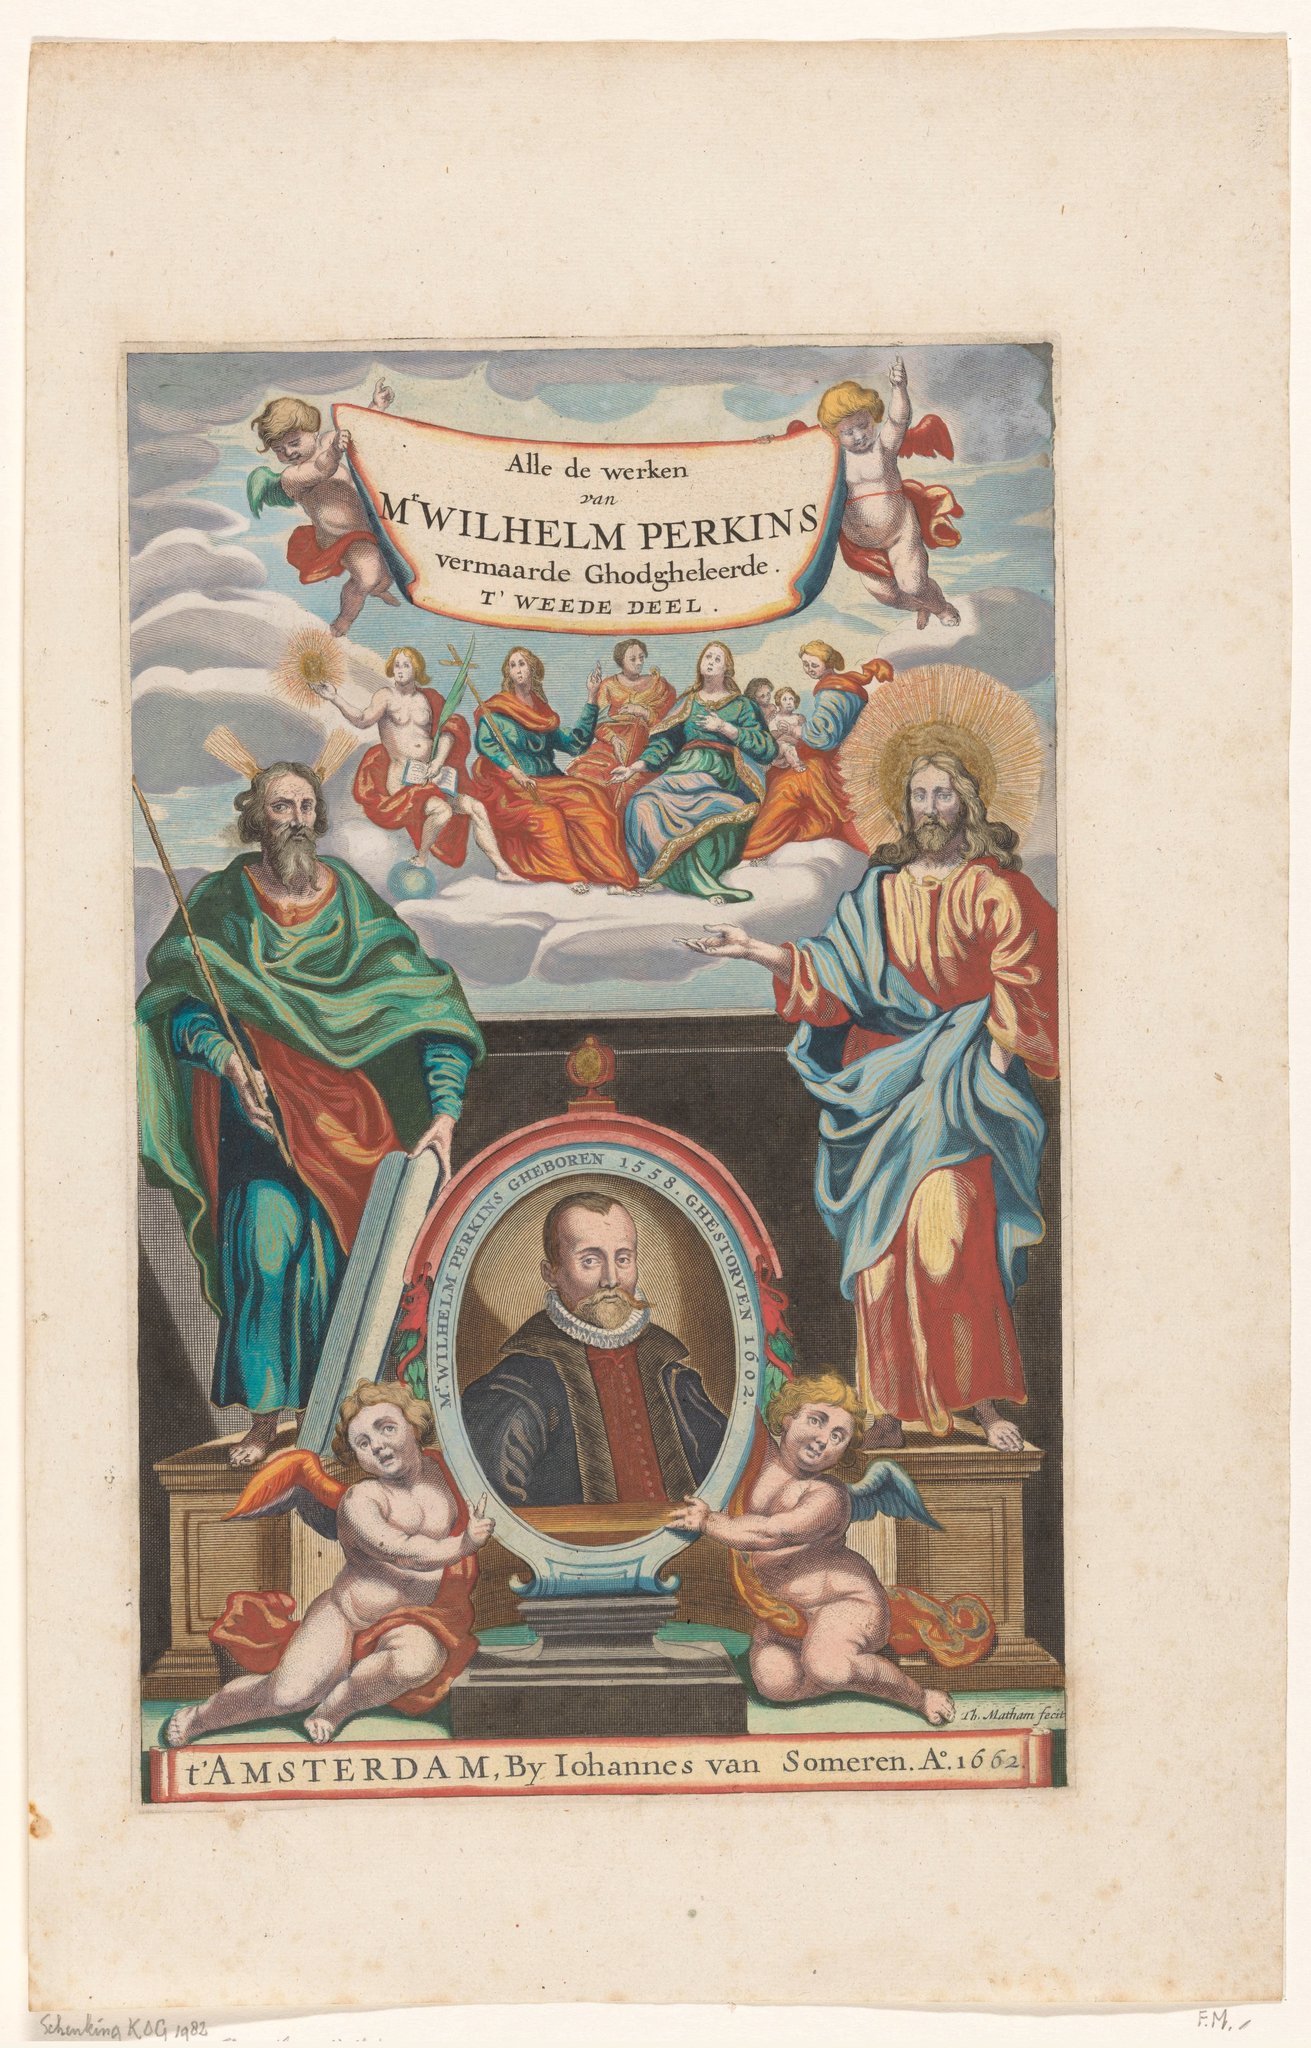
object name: titelblad, titelpagina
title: Portret van William Perkins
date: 1662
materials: paper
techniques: engraving, gilding, hand coloring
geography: amsterdam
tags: portrait of a writer, moses (not in biblical context); possible attributes: rays of light or horns on his head, rod, tables of the law, 'portraits' of christ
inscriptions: collector's mark: Lugt 2228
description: Portret van William Perkins in een ovaal cartouche dat wordt vastgehouden door twee putti. Rechts van het portret Christus en links Mozes. Bovenaan houden twee putti een banderol vast met de titel. Daaronder enkele figuren op een wolkendek, waaronder de drie theologische deugden geloof, hoop en liefde.